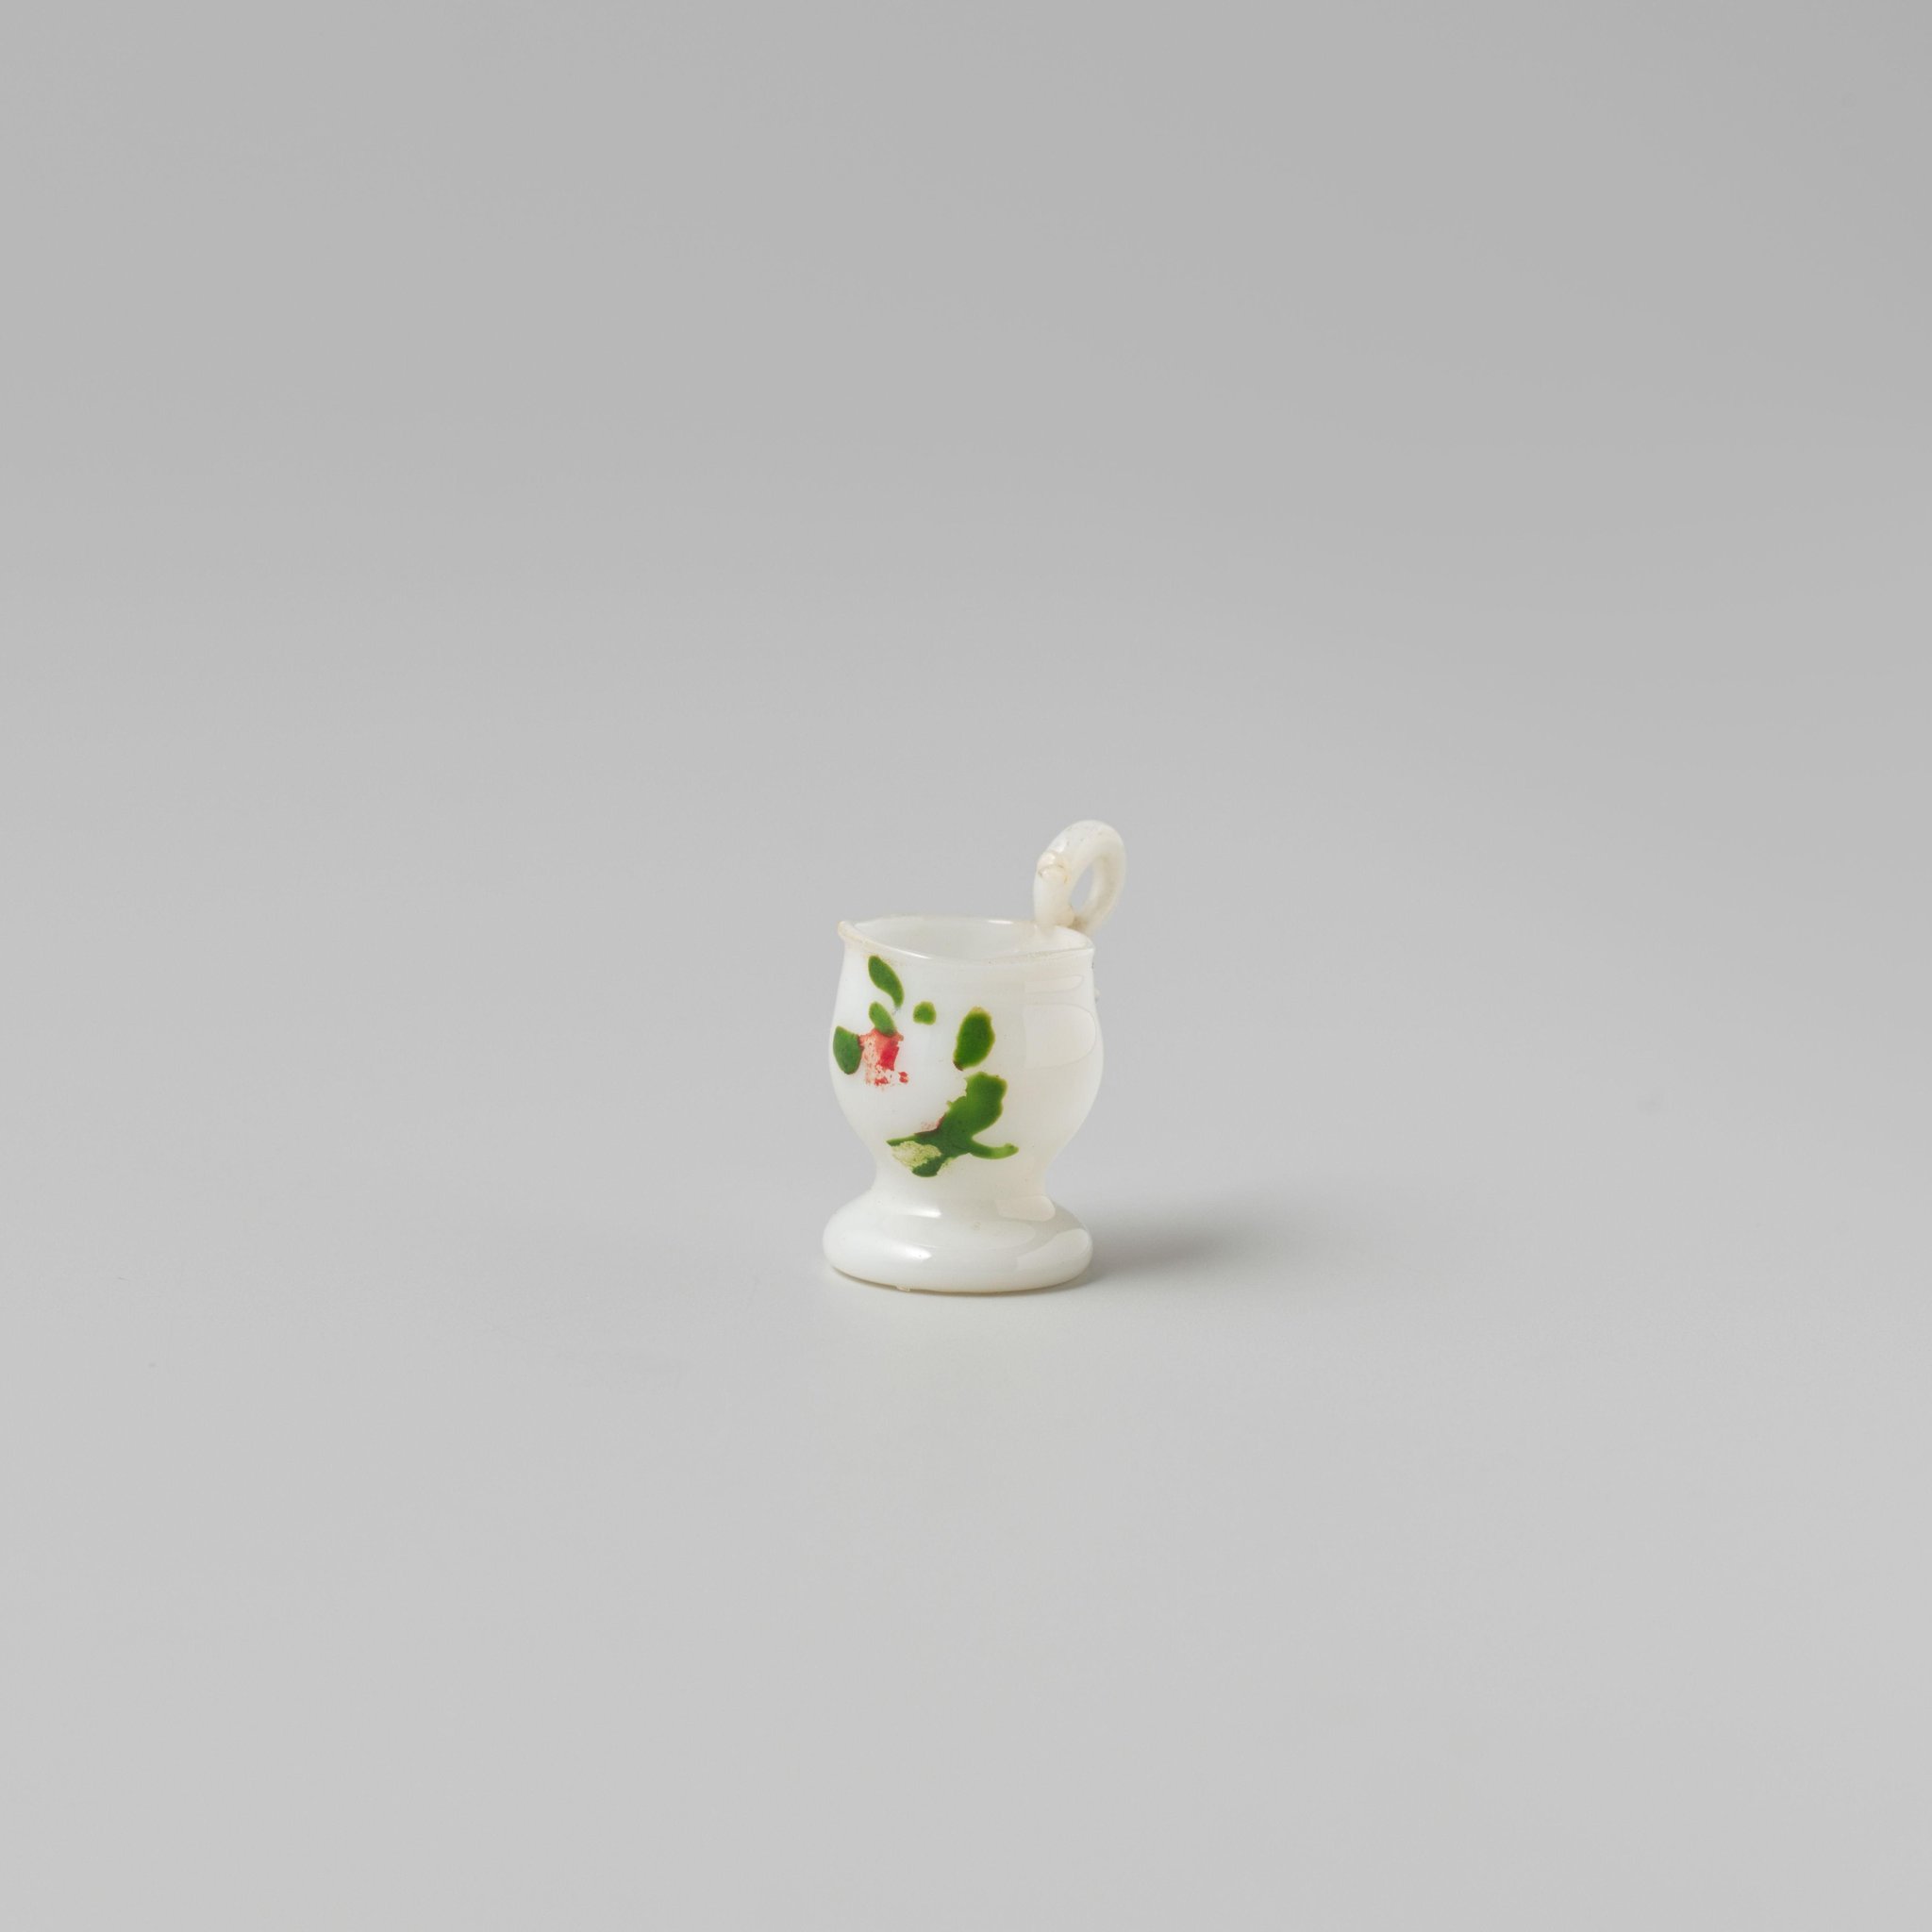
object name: miniature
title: Kop met oor, beschilderd met bloem in wit, rood en groen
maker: Anonymous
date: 1800-1849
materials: glass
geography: bristol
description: Kop van opaak wit glas, bol model op voet, met s-vormig oor. De kop is beschilderd met een bloem in wit, rood en groen.